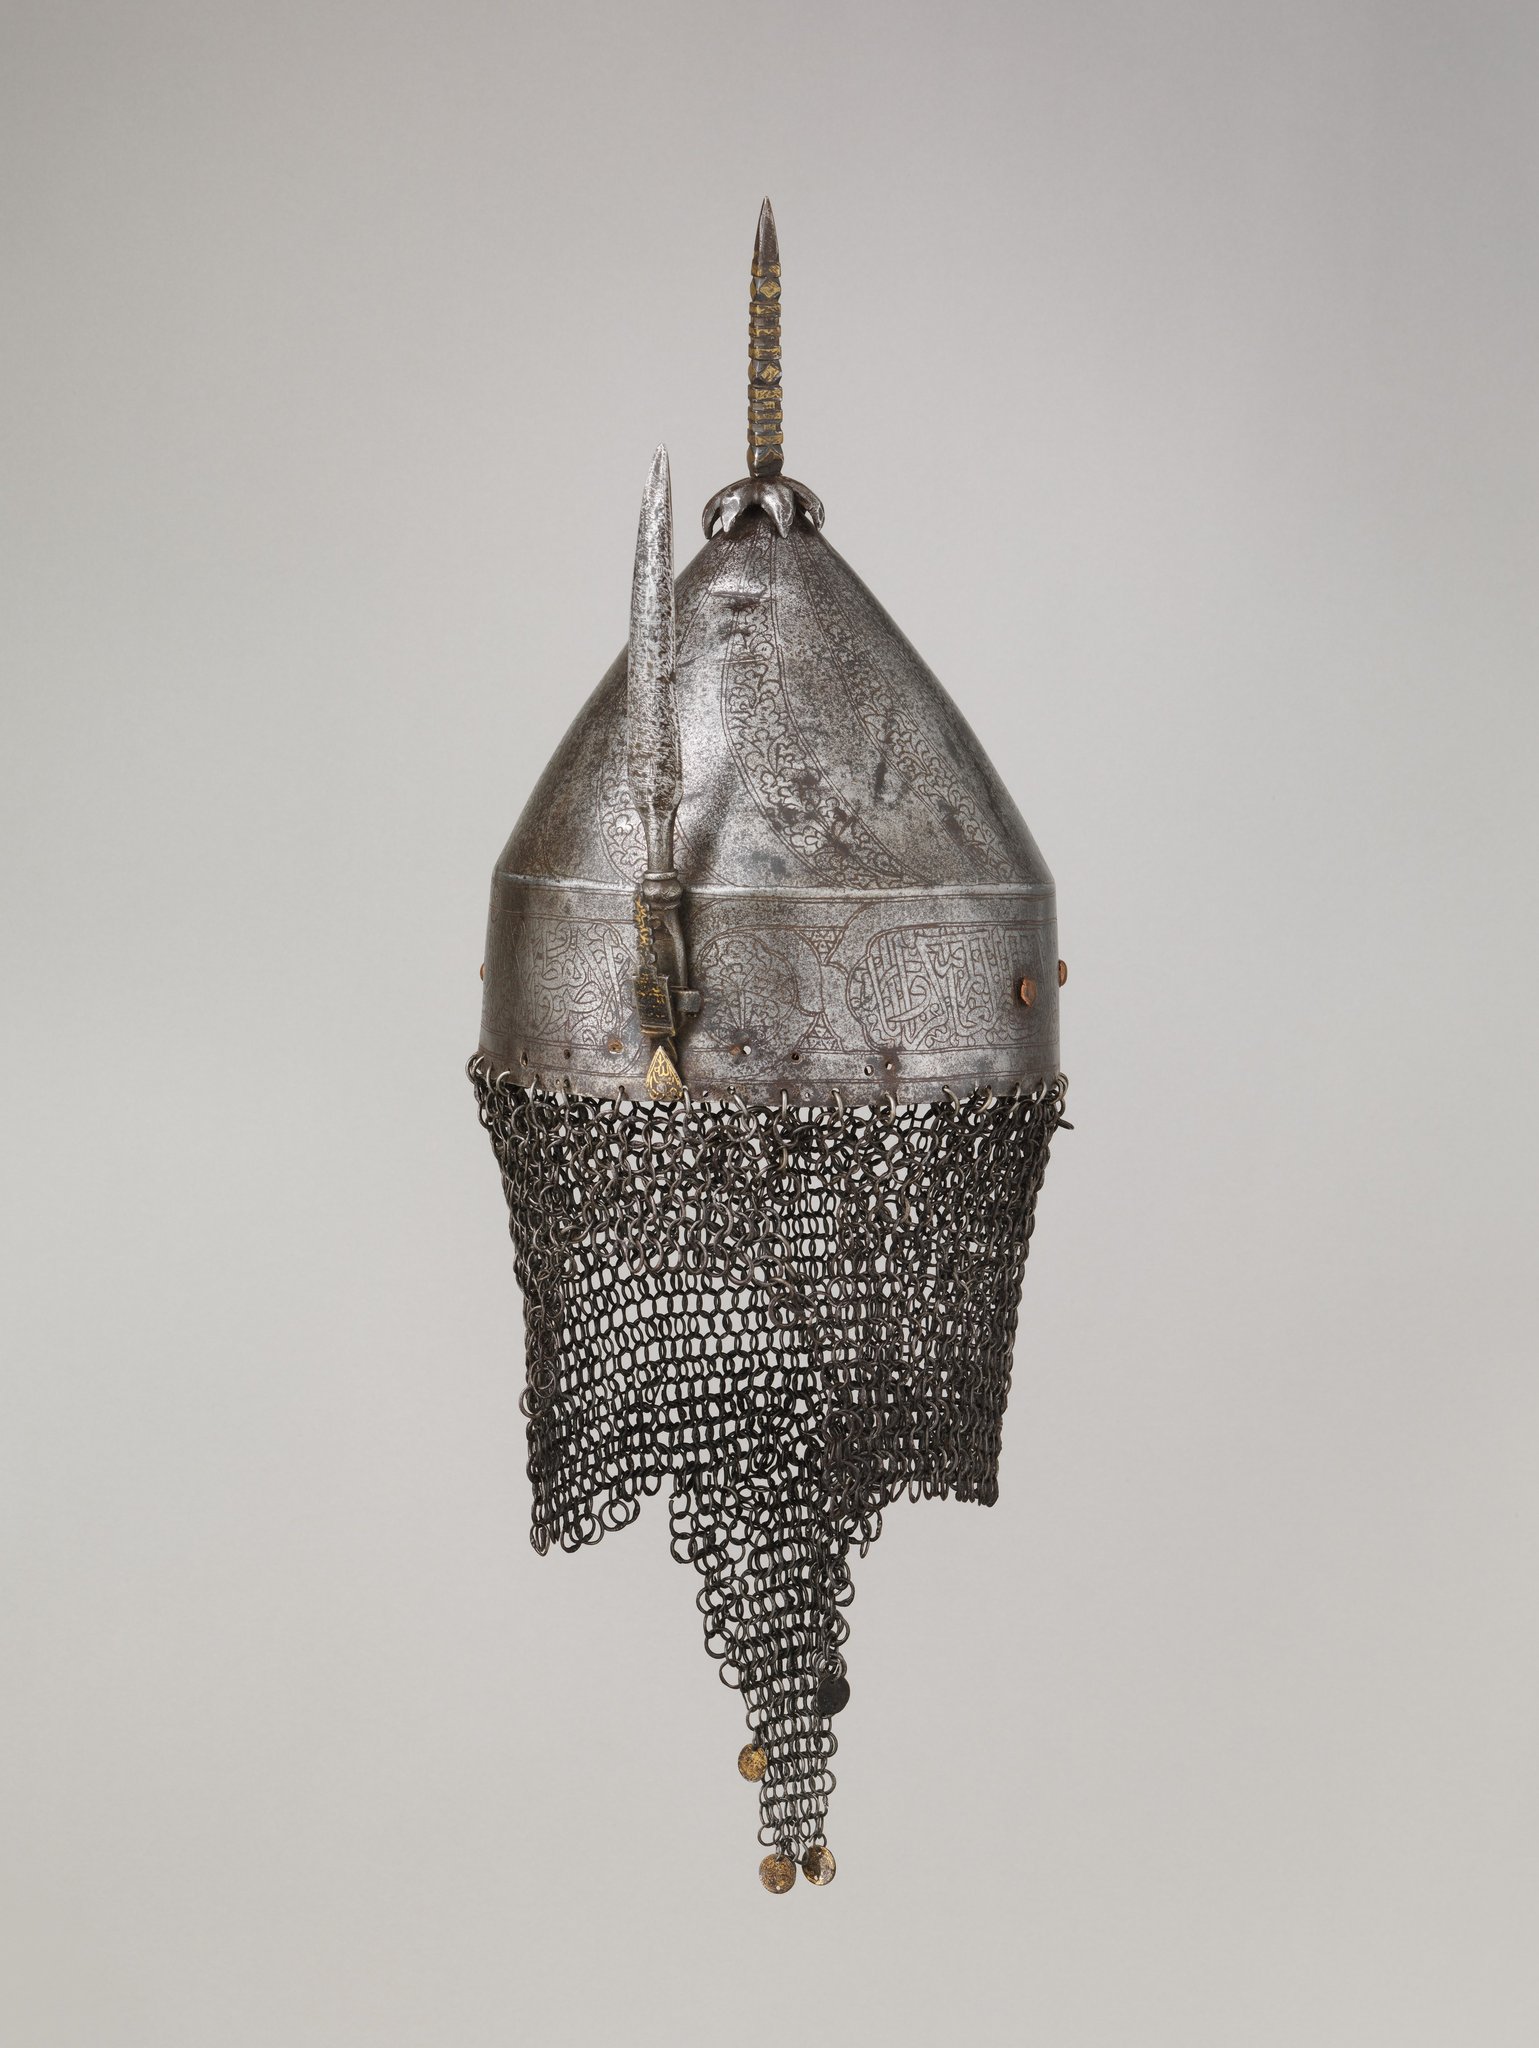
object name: helmet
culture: egyptian or syrian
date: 1515-1520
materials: copper alloy, gold, iron, steel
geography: syria